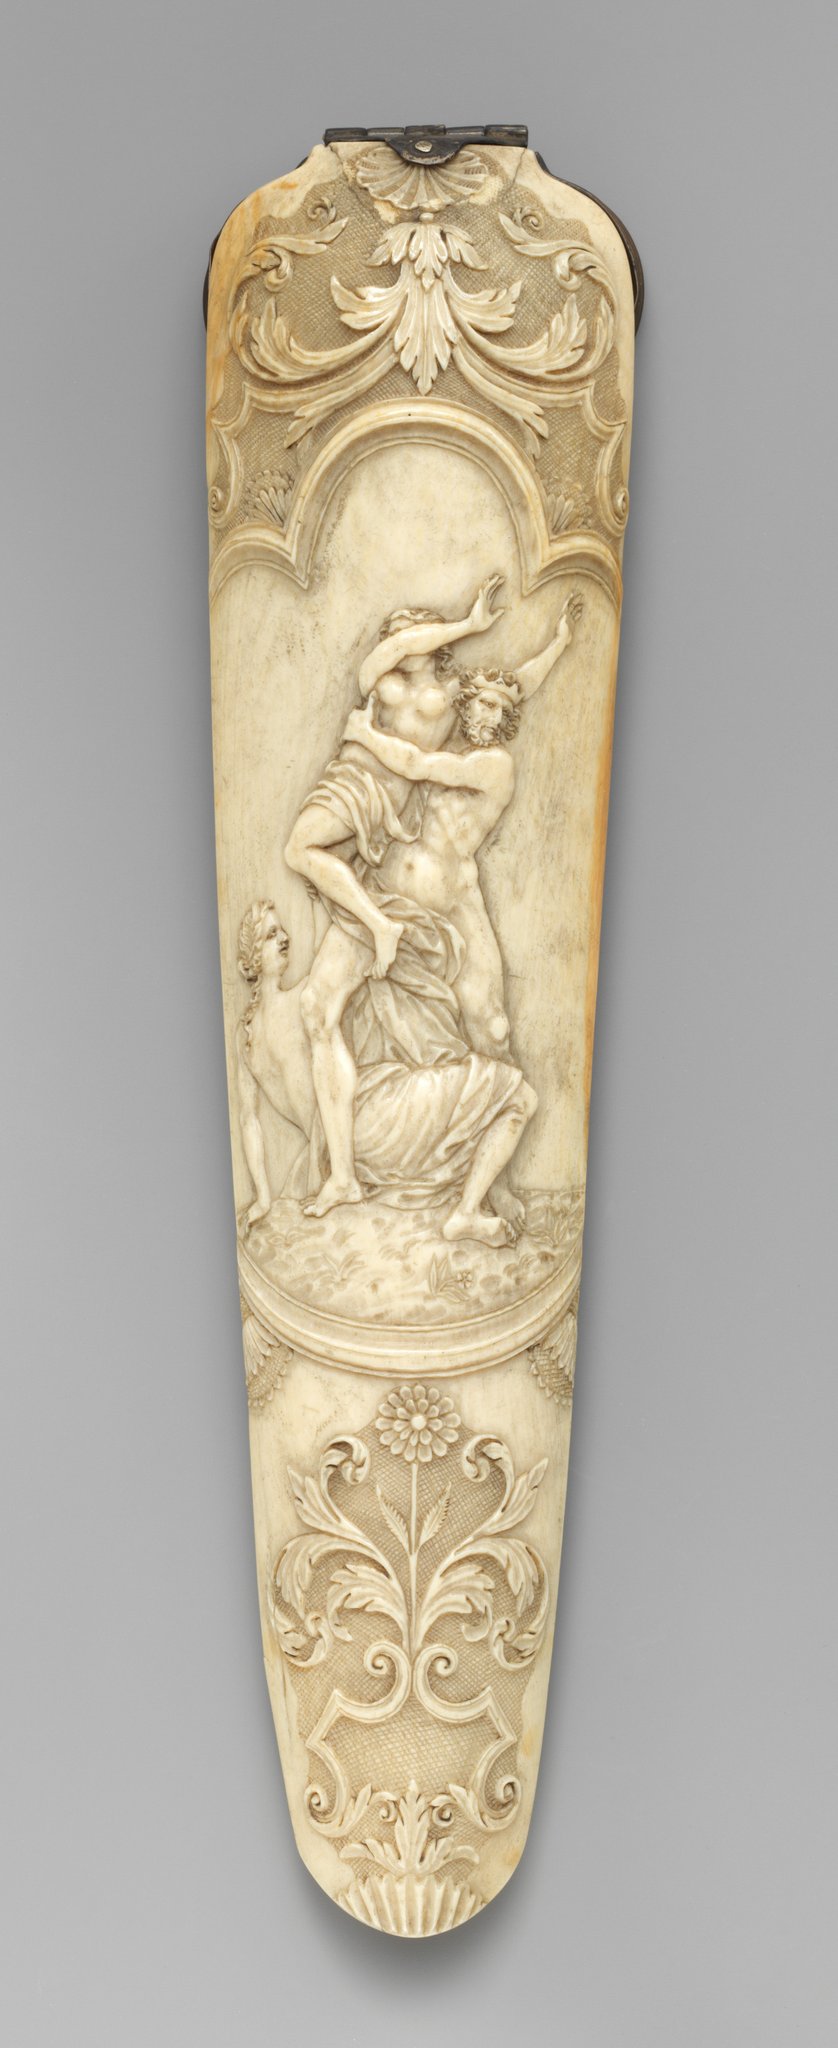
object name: tobacco rasp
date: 1701-1800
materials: copper, ivory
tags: eagles,male nudes,female nudes